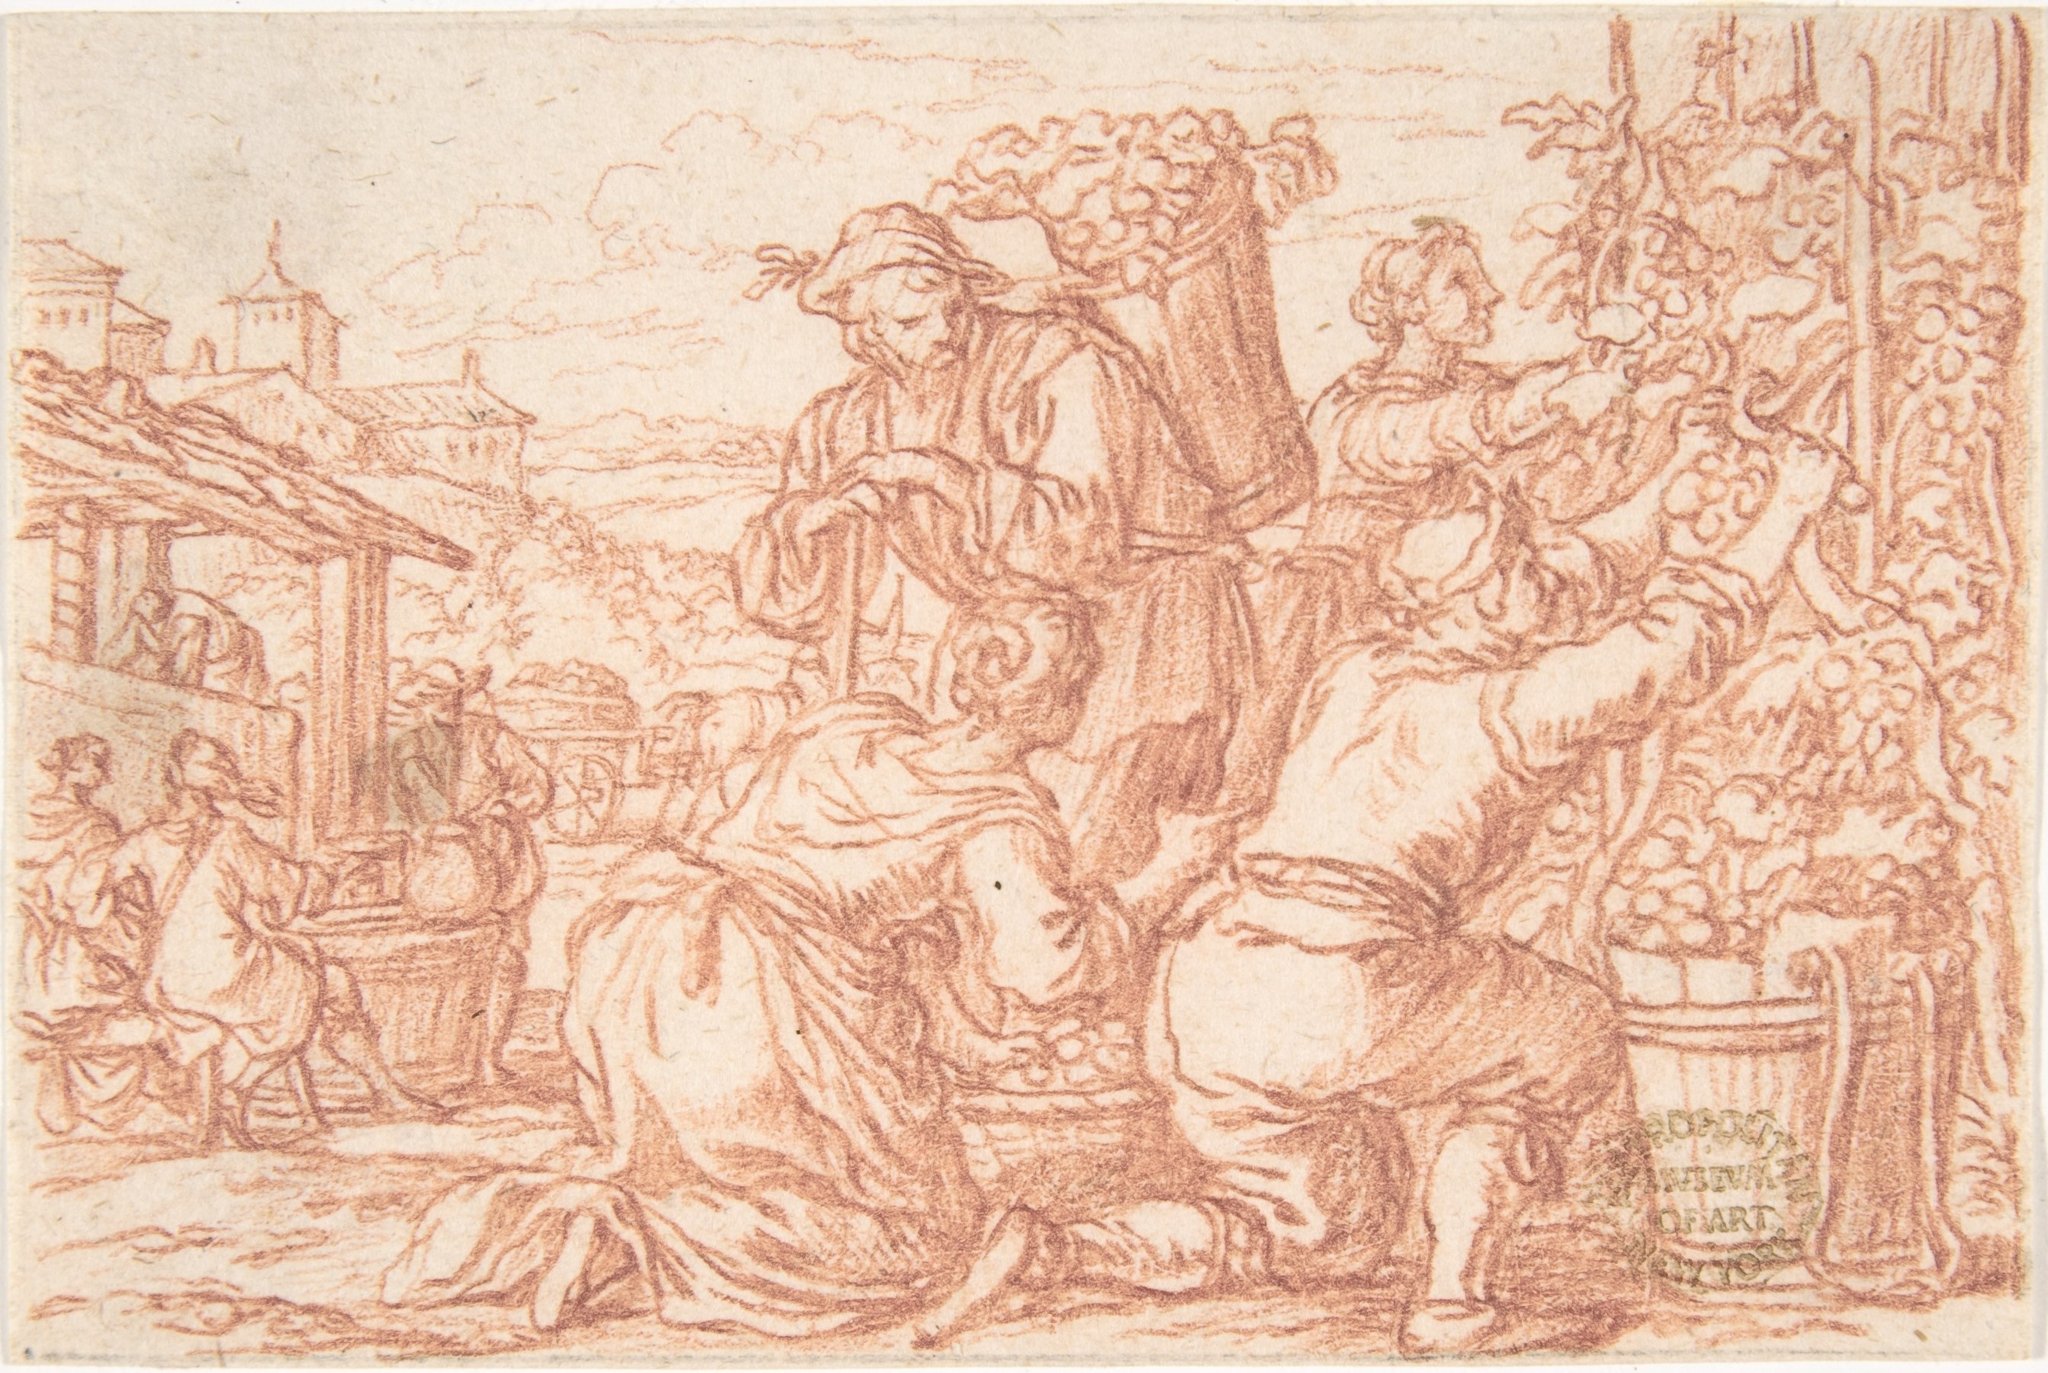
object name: drawing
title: October (one of a series representing the labors of the months)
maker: jonas umbach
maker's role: artist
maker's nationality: german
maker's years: 1624-1693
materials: chalk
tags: houses,men,women,working